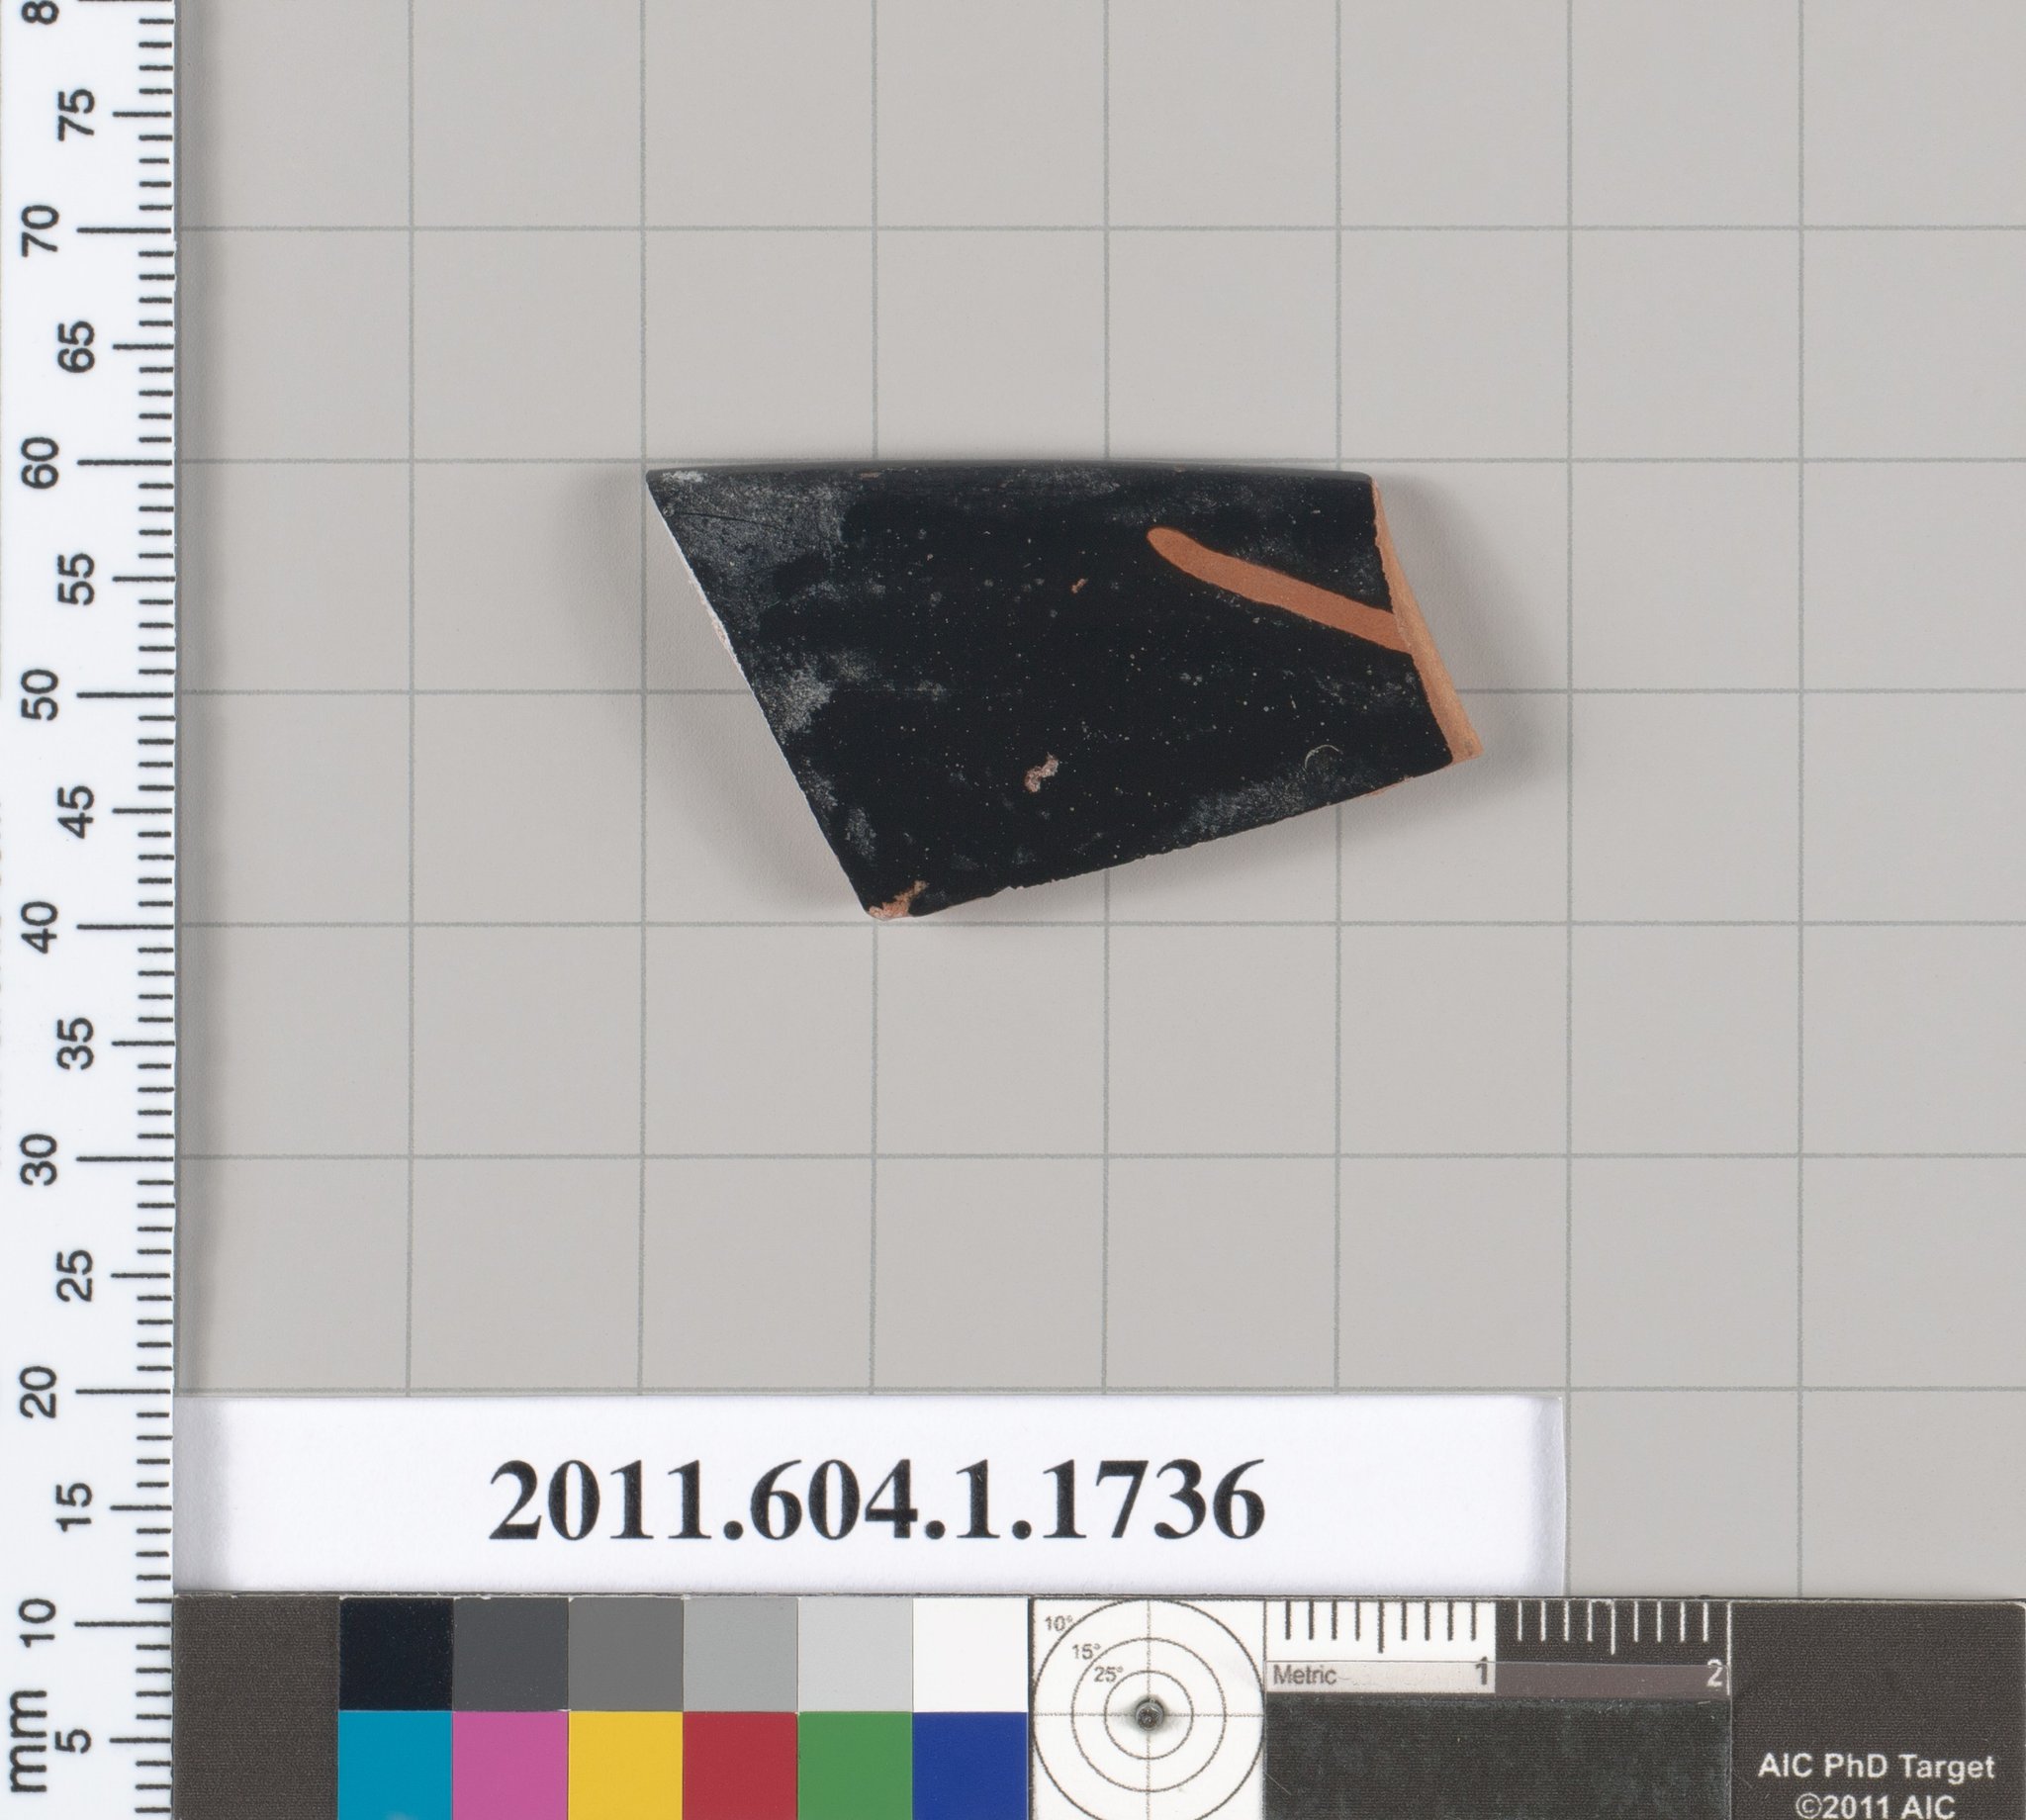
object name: kylix fragment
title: Terracotta rim fragment of a kylix (drinking cup)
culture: greek, attic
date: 475-451 BCE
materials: terracotta